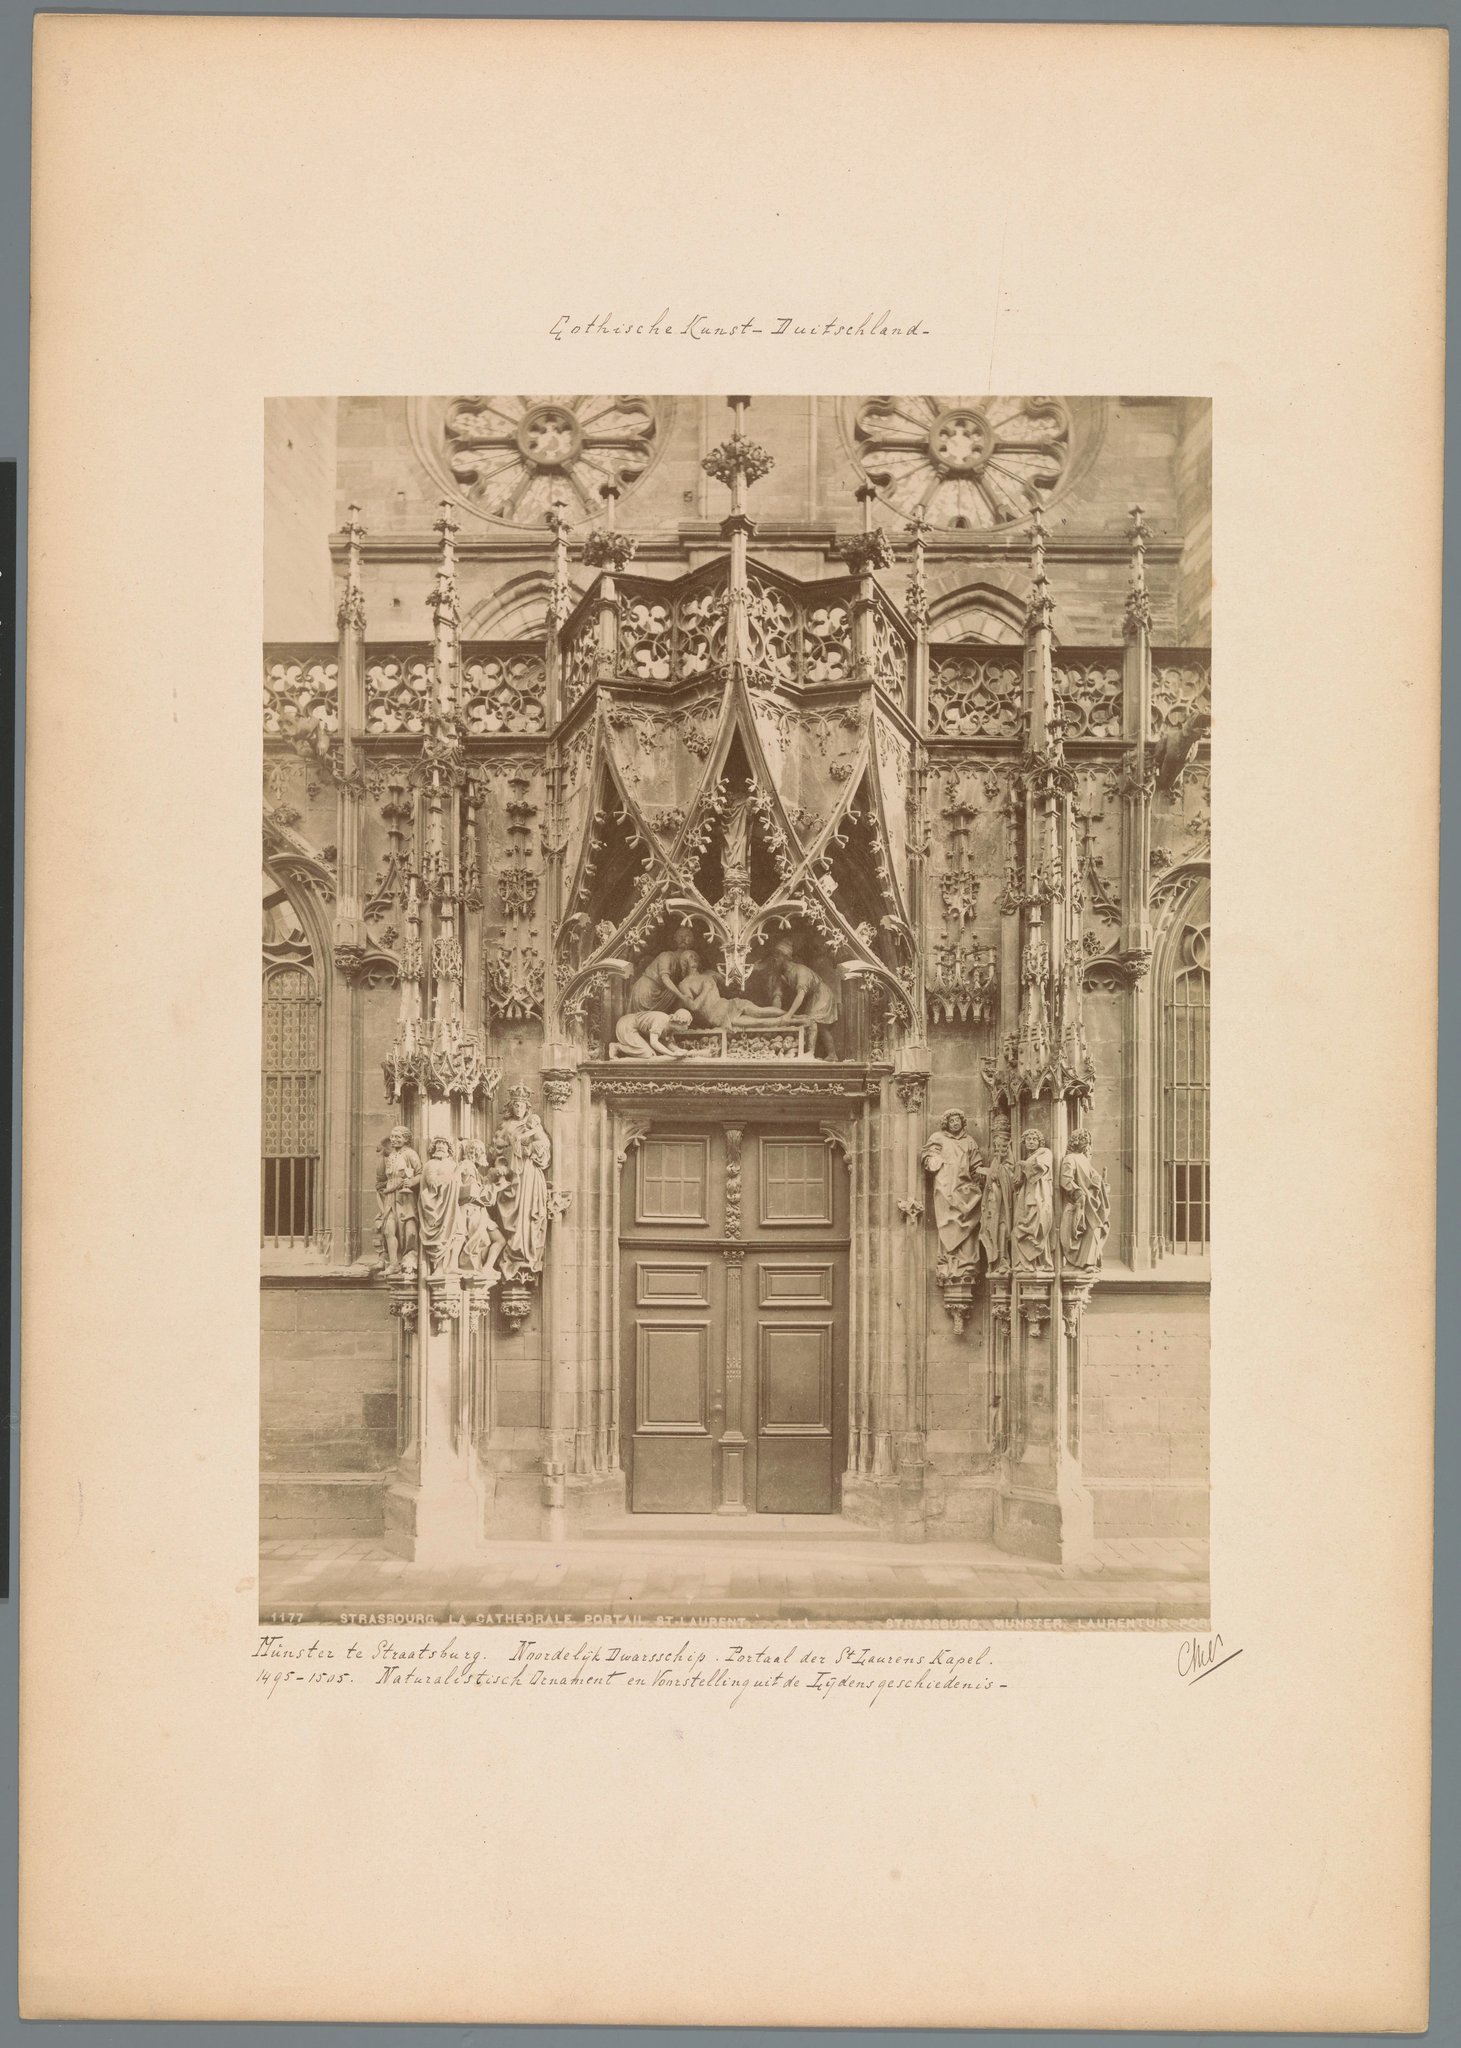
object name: photograph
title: Portaal van de Sint-Laurentiuskapel van de kathedraal de Notre-Dame te Straatsburg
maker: Anonymous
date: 1875-1900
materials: cardboard, photographic support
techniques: albumen print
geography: straatsburg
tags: parts of church exterior and annexes: portal, sculpture (+ relief ~ sculpture)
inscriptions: inscription: ‘CWN.’, number: ‘1177’, collector's mark: ‘KUNSTNIJVERHEIDSCHOOL QUELLINUS AMSTERDAM FRANS HALSSTRAAT 14.’, inscription: ‘Gothische Kunst - Duitschland.’, collector's mark: ‘INSTITUUT VOOR KUNST-NIJVERHEIDSONDERWIJS GABRIËL METSUSTRAAT No. 16 AMSTERDAM’